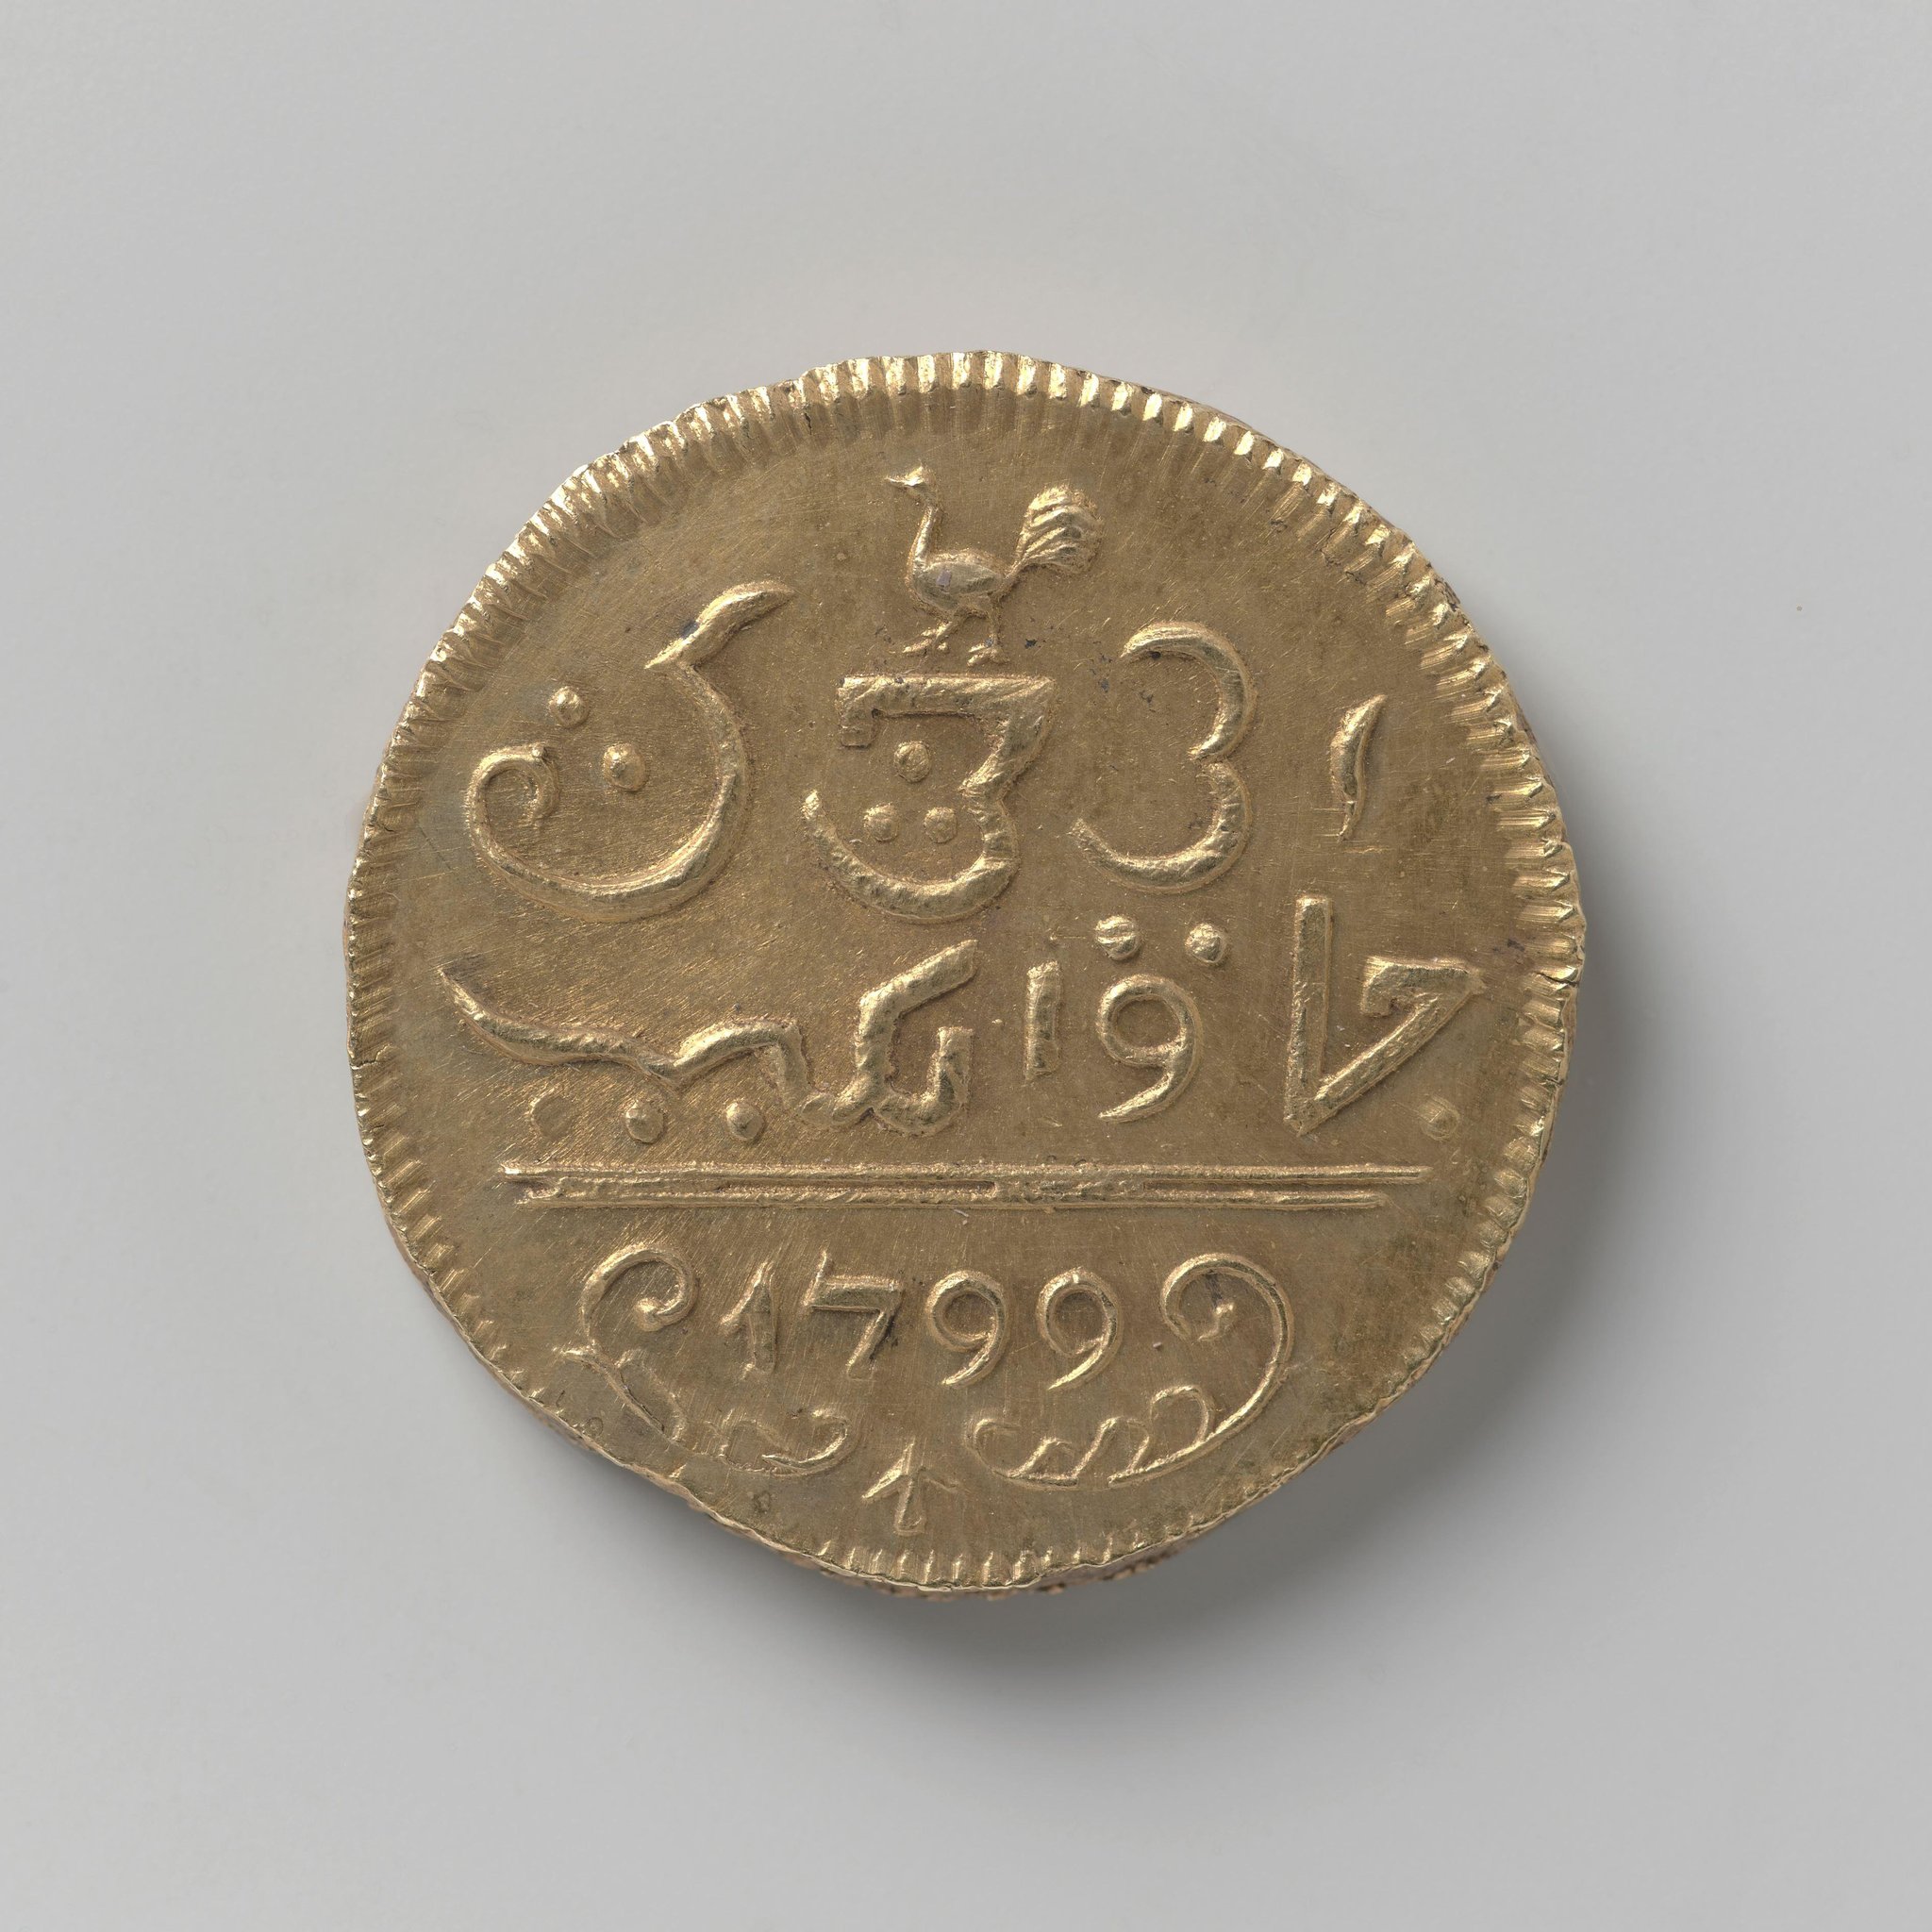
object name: coin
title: VOC, halve gouden Javase ropij, 1799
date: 1799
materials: gold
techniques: striking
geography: batavia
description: Gouden munt. Voorzijde: tweeregelig opschrift in Arabische letters. Daarboven muntmeesterteken en daaronder dubbellijnige balk, waaronder jaartal in versiering. Keerzijde: drieregelig opschrift in Arabische letters. Daarboven en daaronder een touwstrik. Kabelrand.